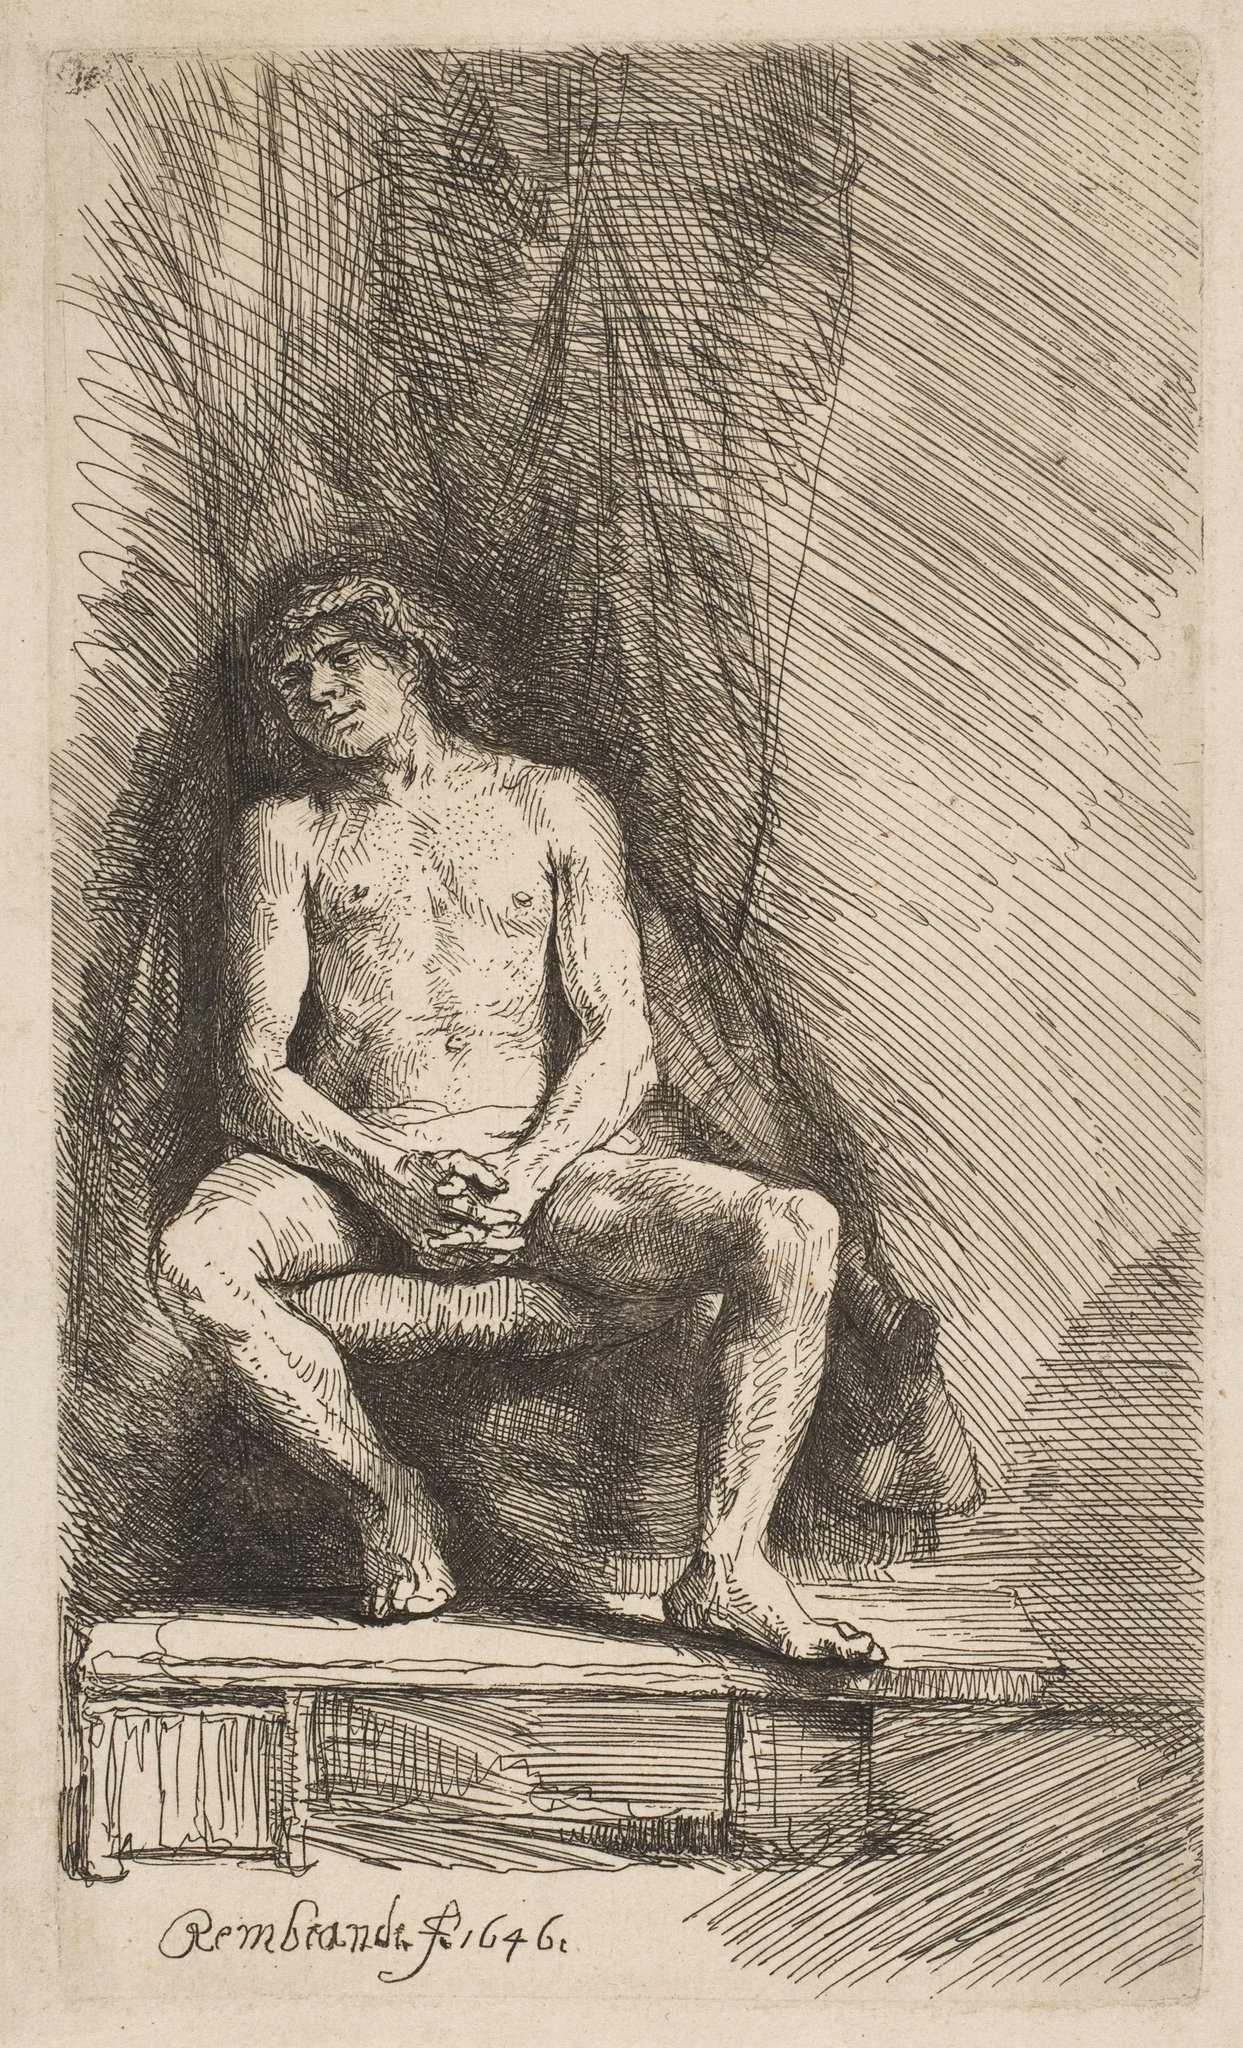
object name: print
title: Nude Man Seated before a Curtain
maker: rembrandt van rijn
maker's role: artist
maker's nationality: dutch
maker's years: 1606-1669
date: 1646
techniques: etching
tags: male nudes